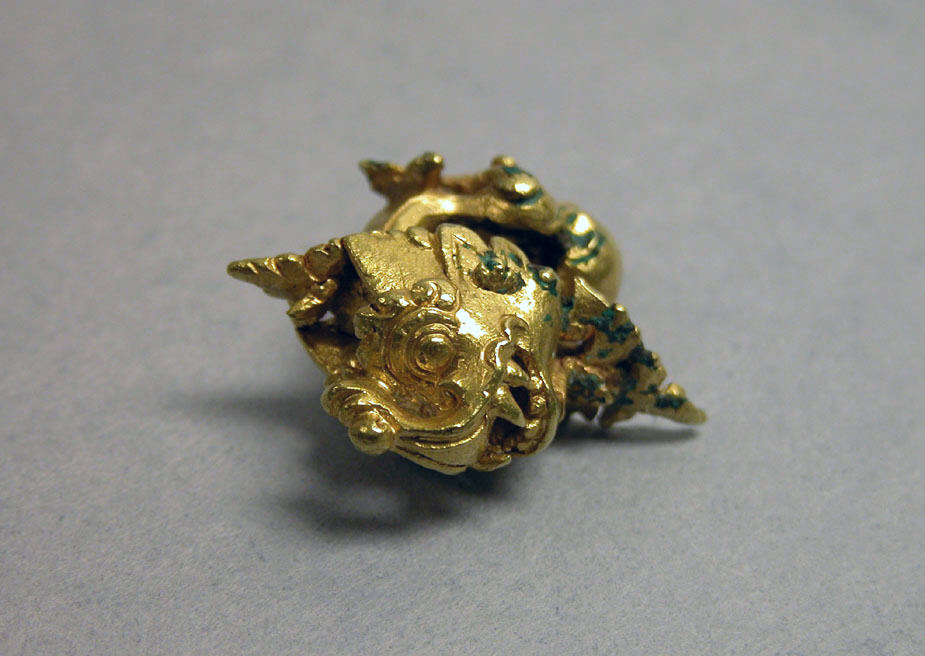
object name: ear ornament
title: Ear Ornament with Makara Motif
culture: indonesian, javanese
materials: gold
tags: mythical creatures